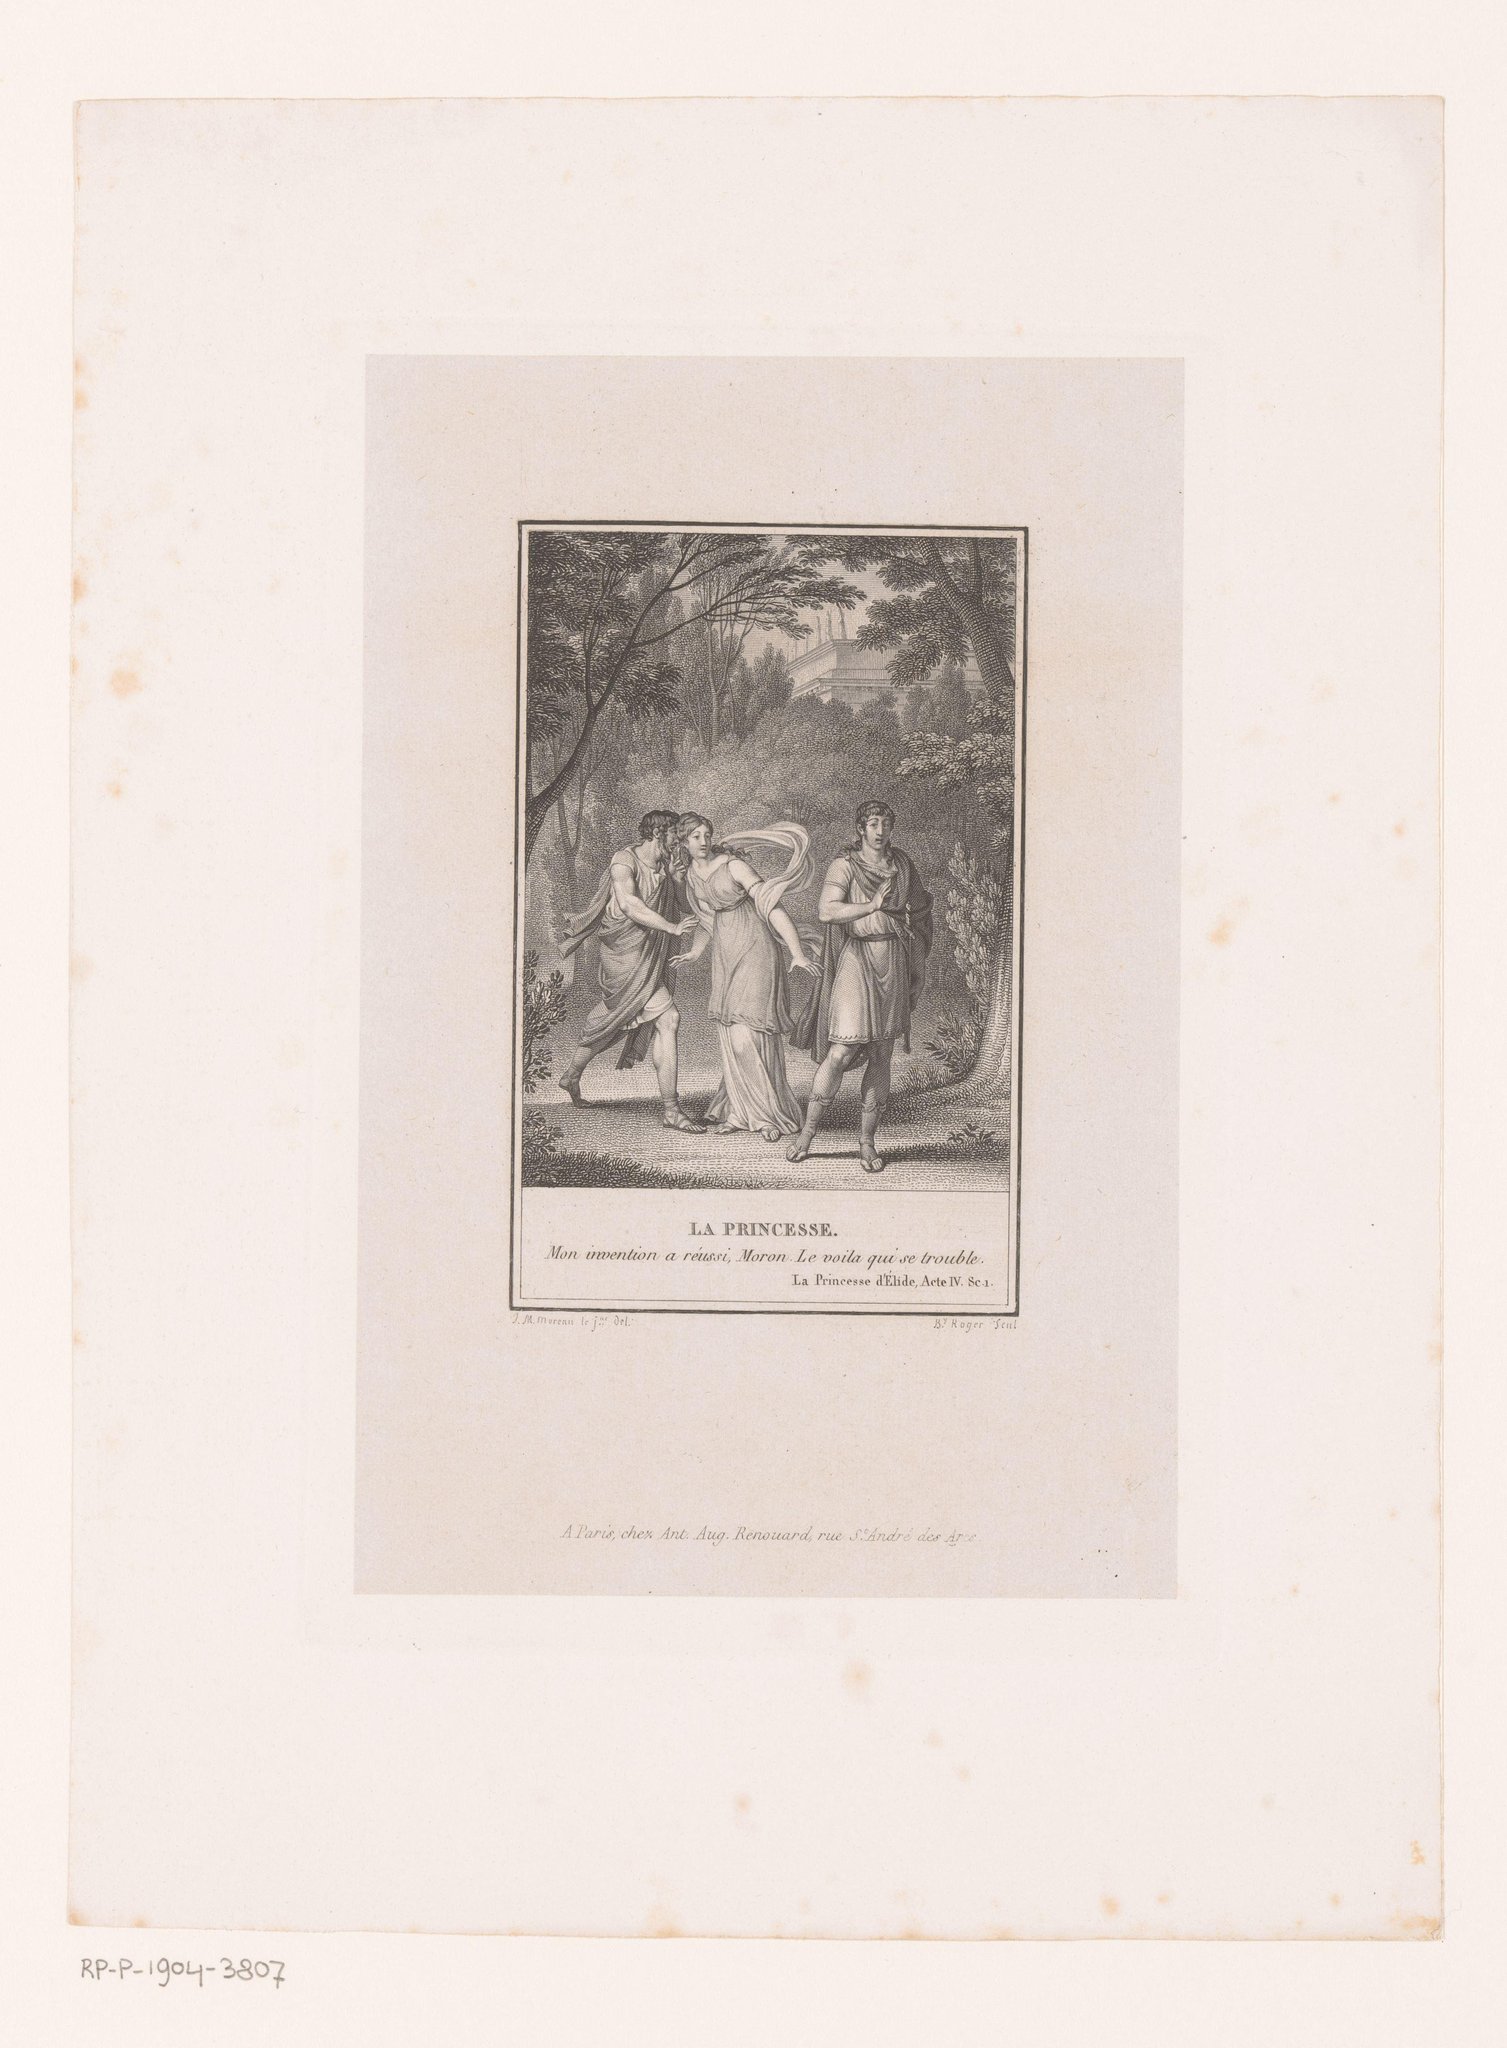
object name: book illustration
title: Moron fluistert iets in het oor van de prinses van Elide, die naar prins Euryale kijkt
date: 1811-1813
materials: paper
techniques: engraving, etching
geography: paris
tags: theatre, theatrical performance, princess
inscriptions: collector's mark: Lugt 2228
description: Prent van scène één uit de vierde acte van 'La Princesse d'Élide' door Jean Baptiste Molière. Dit betreft één van de dertig prenten, gemaakt in opdracht van Antoine Augustin Renouard, bestemd voor verschillende edities van Molières werk daterend van 1811 tot 1813. De prenten zijn vervaardigd door verschillende kunstenaars naar composities van Moreau.